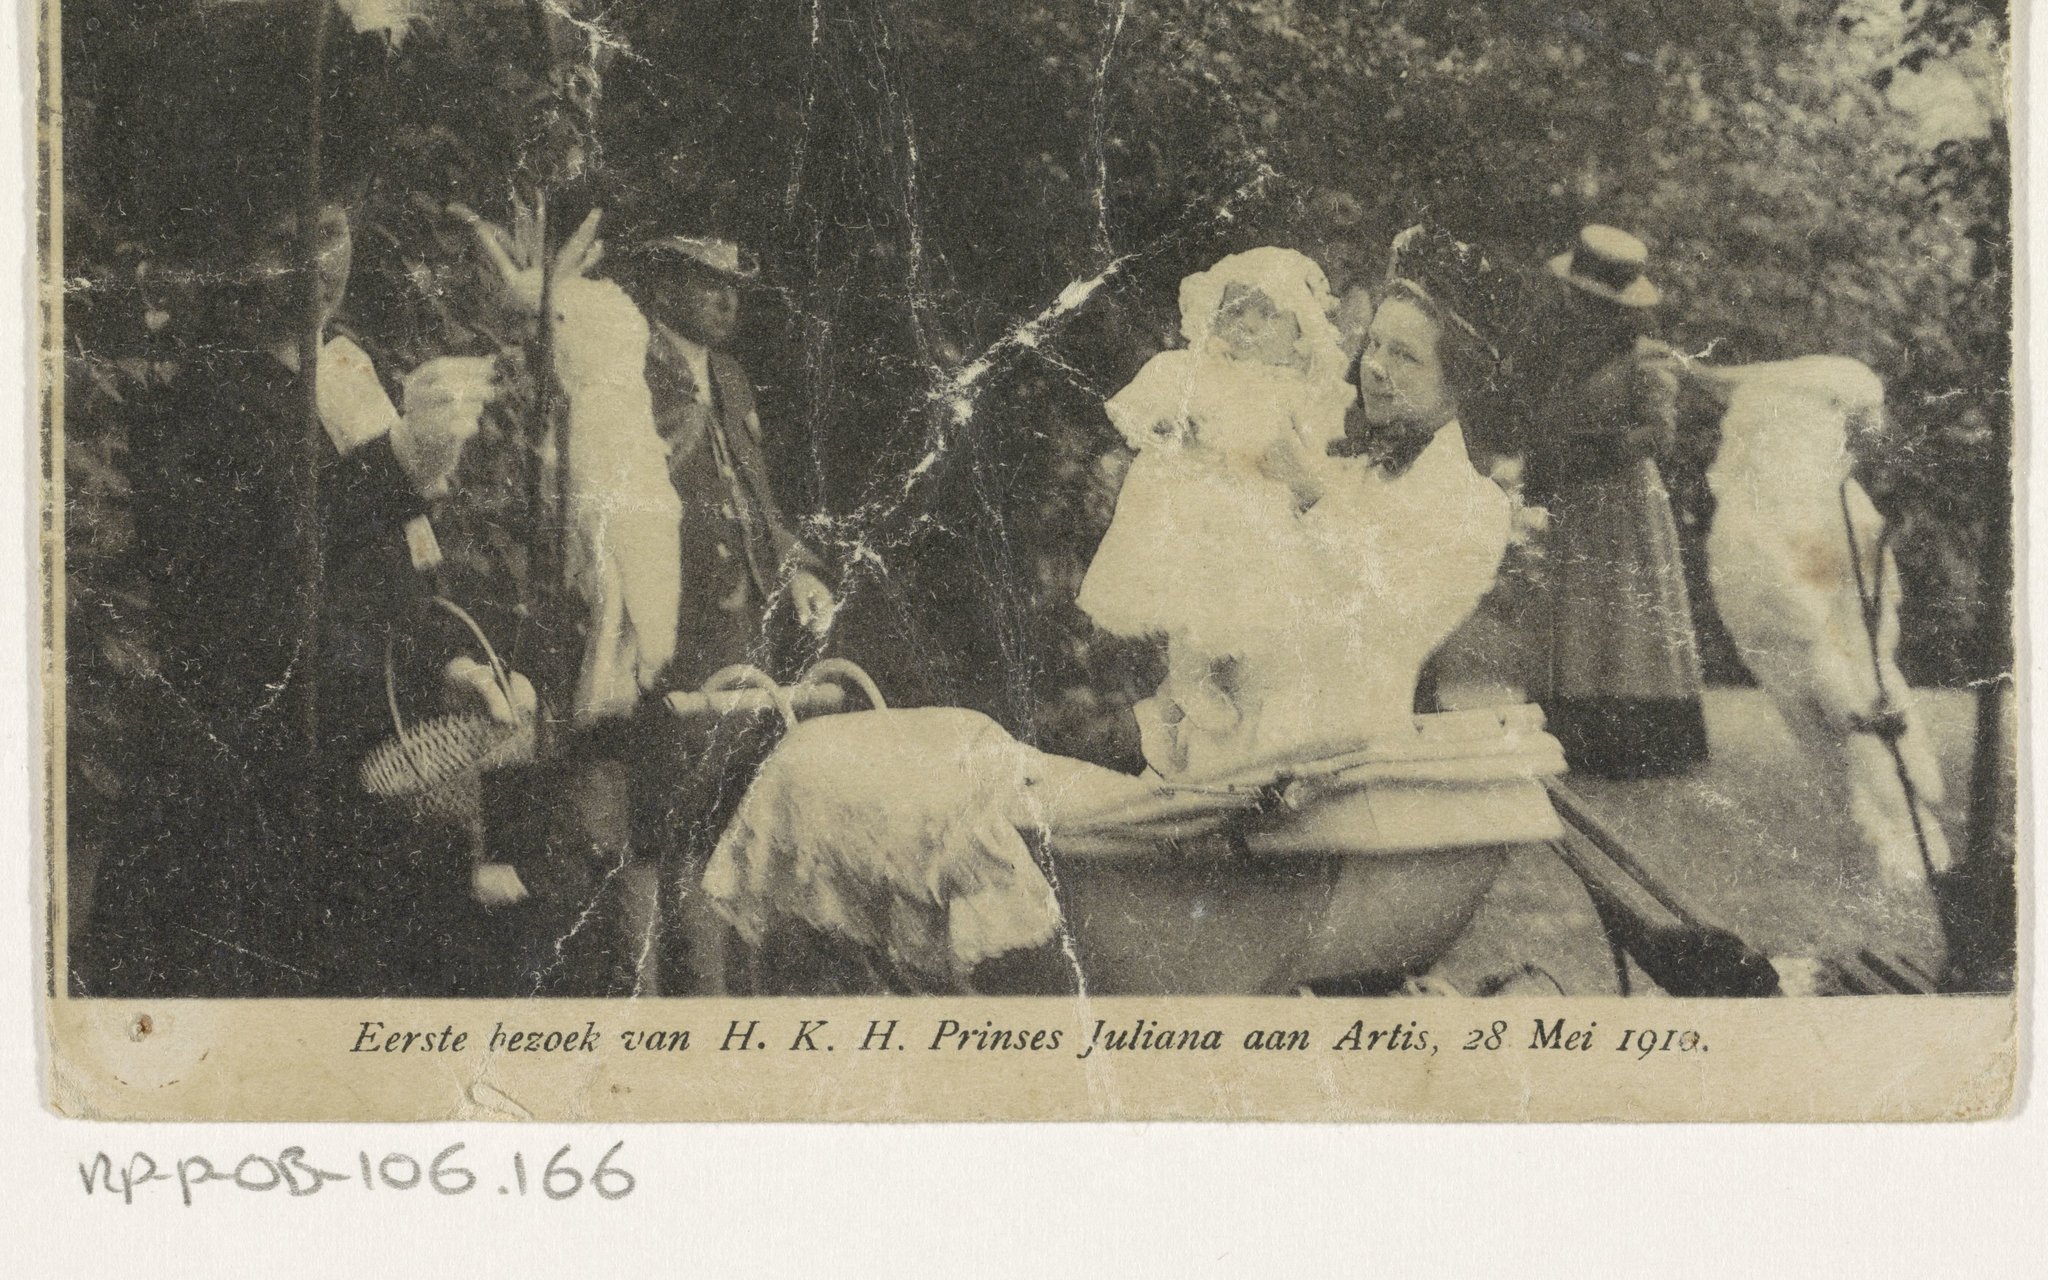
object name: ansichtkaart, prentbriefkaart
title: Bezoek van Juliana, koningin der Nederlanden, aan Artis te Amsterdam op 28 mei 1910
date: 1910-1912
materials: paper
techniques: photograph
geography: netherlands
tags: the hague, juliana of the netherlands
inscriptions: inscription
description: De hier vermelde titel verwijst naar de hoogst verkregen titel van de geportretteerde, niet per se naar de titel die de geportretteerde op deze voorstelling draagt.